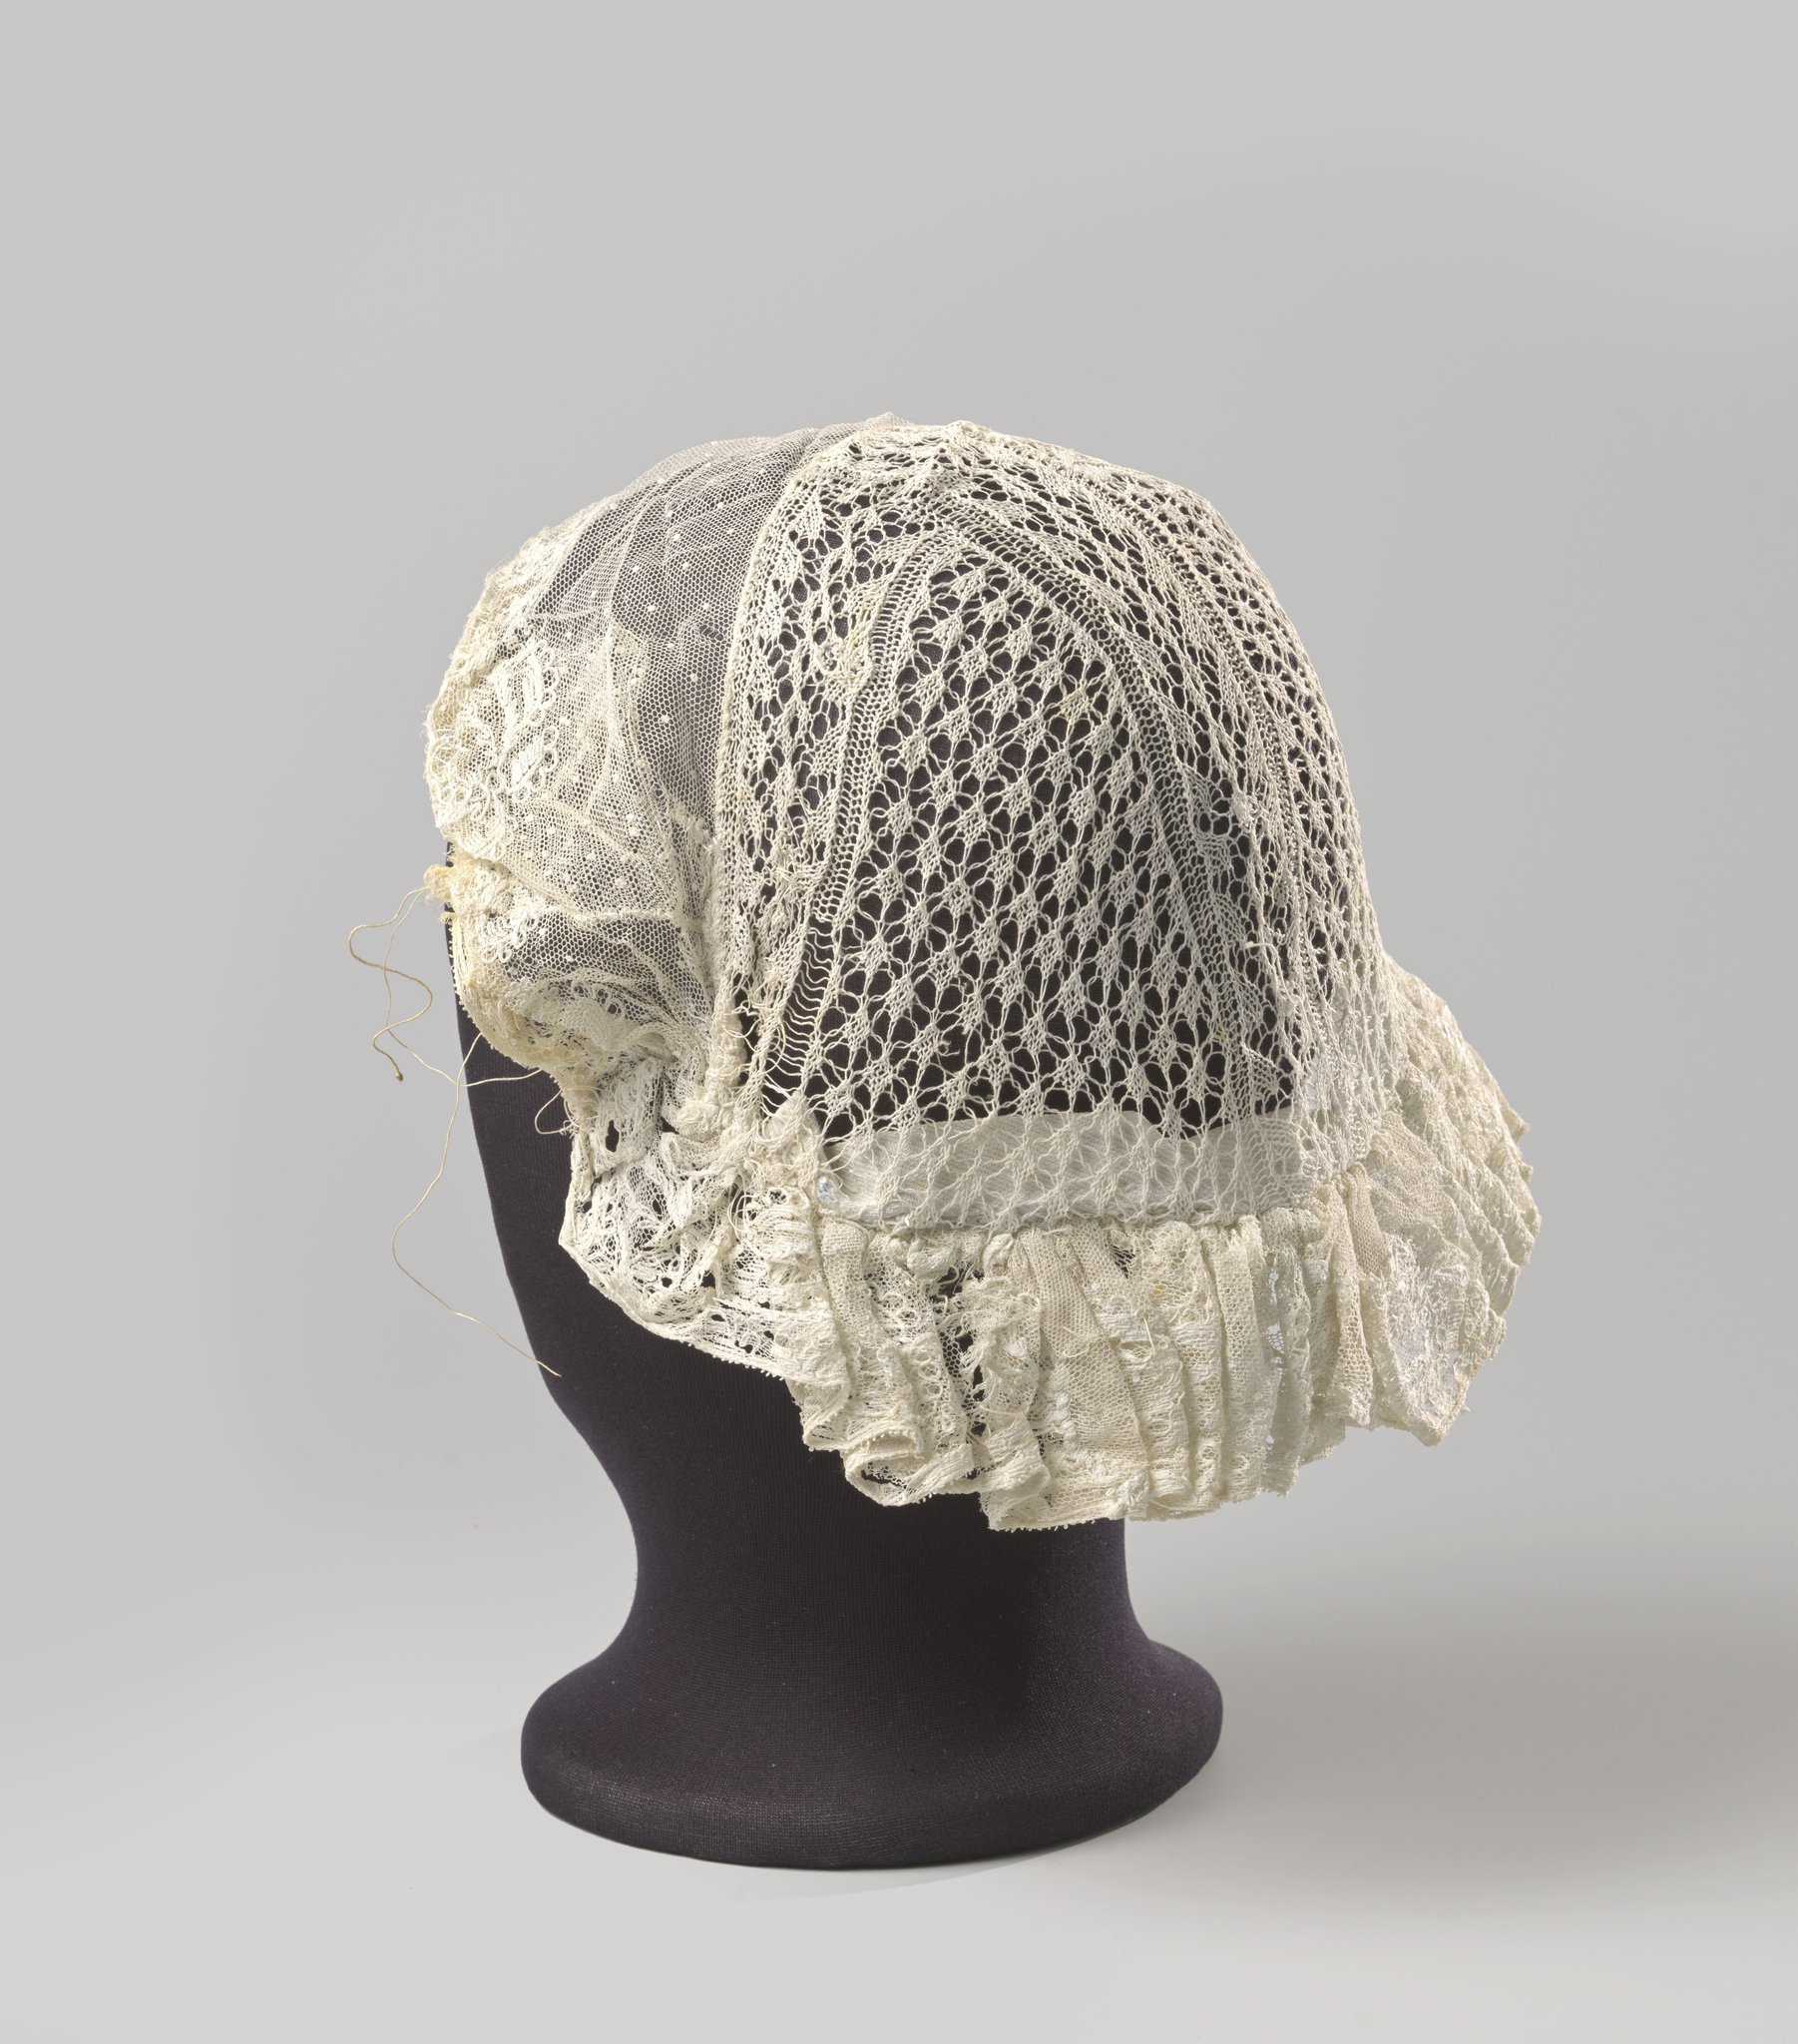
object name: womenswear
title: Muts met bol van Friese kant in fijn breiwerk, afgezet met een strook tule versierd met doorstopwerk; de strook is langs het voorhoofd geplooid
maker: Anonymous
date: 1800-1900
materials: linen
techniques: material, knitting, weave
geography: friesland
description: Muts met bol van Friese kant in fijn breiwerk, afgezet met een strook tule versierd met doorstopwerk. De strook is langs het voorhoofd geplooid.